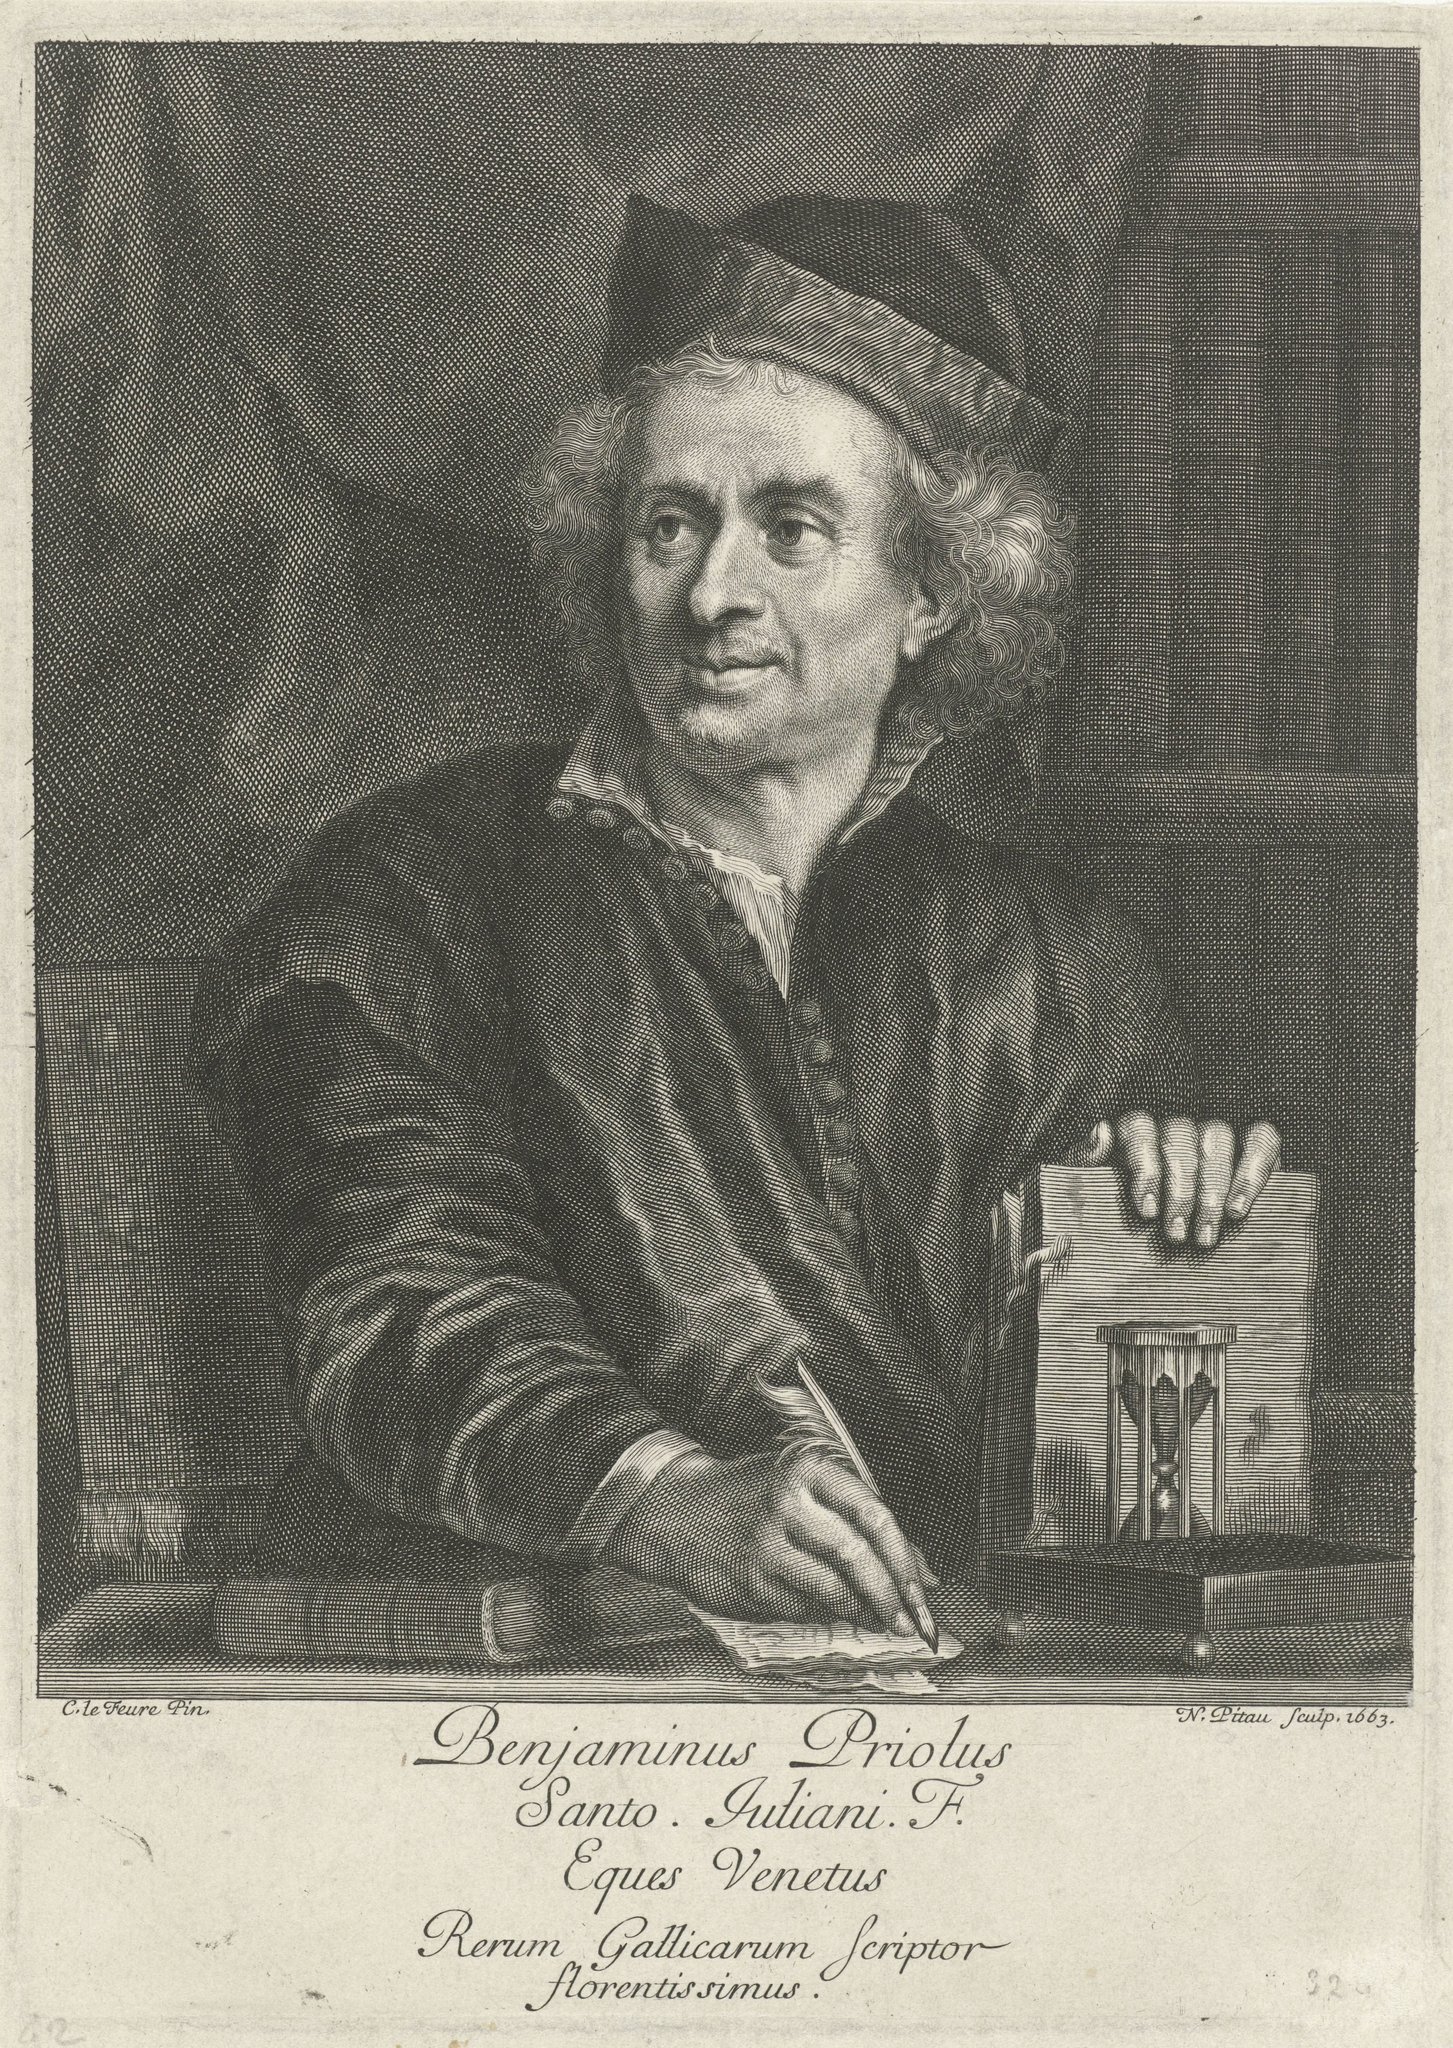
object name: print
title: Portret van Benjamin Priolo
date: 1663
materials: paper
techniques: engraving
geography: paris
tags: writing tools, study; 'studiolo'; library, book, hourglass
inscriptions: collector's mark: Lugt 240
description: Portret van de Italiaanse historicus Benjamin Priolo. Hij zit in zijn studeervertrek en schrijft op een vel papier. In de marge een vijfregelig onderschrift in het Latijn.